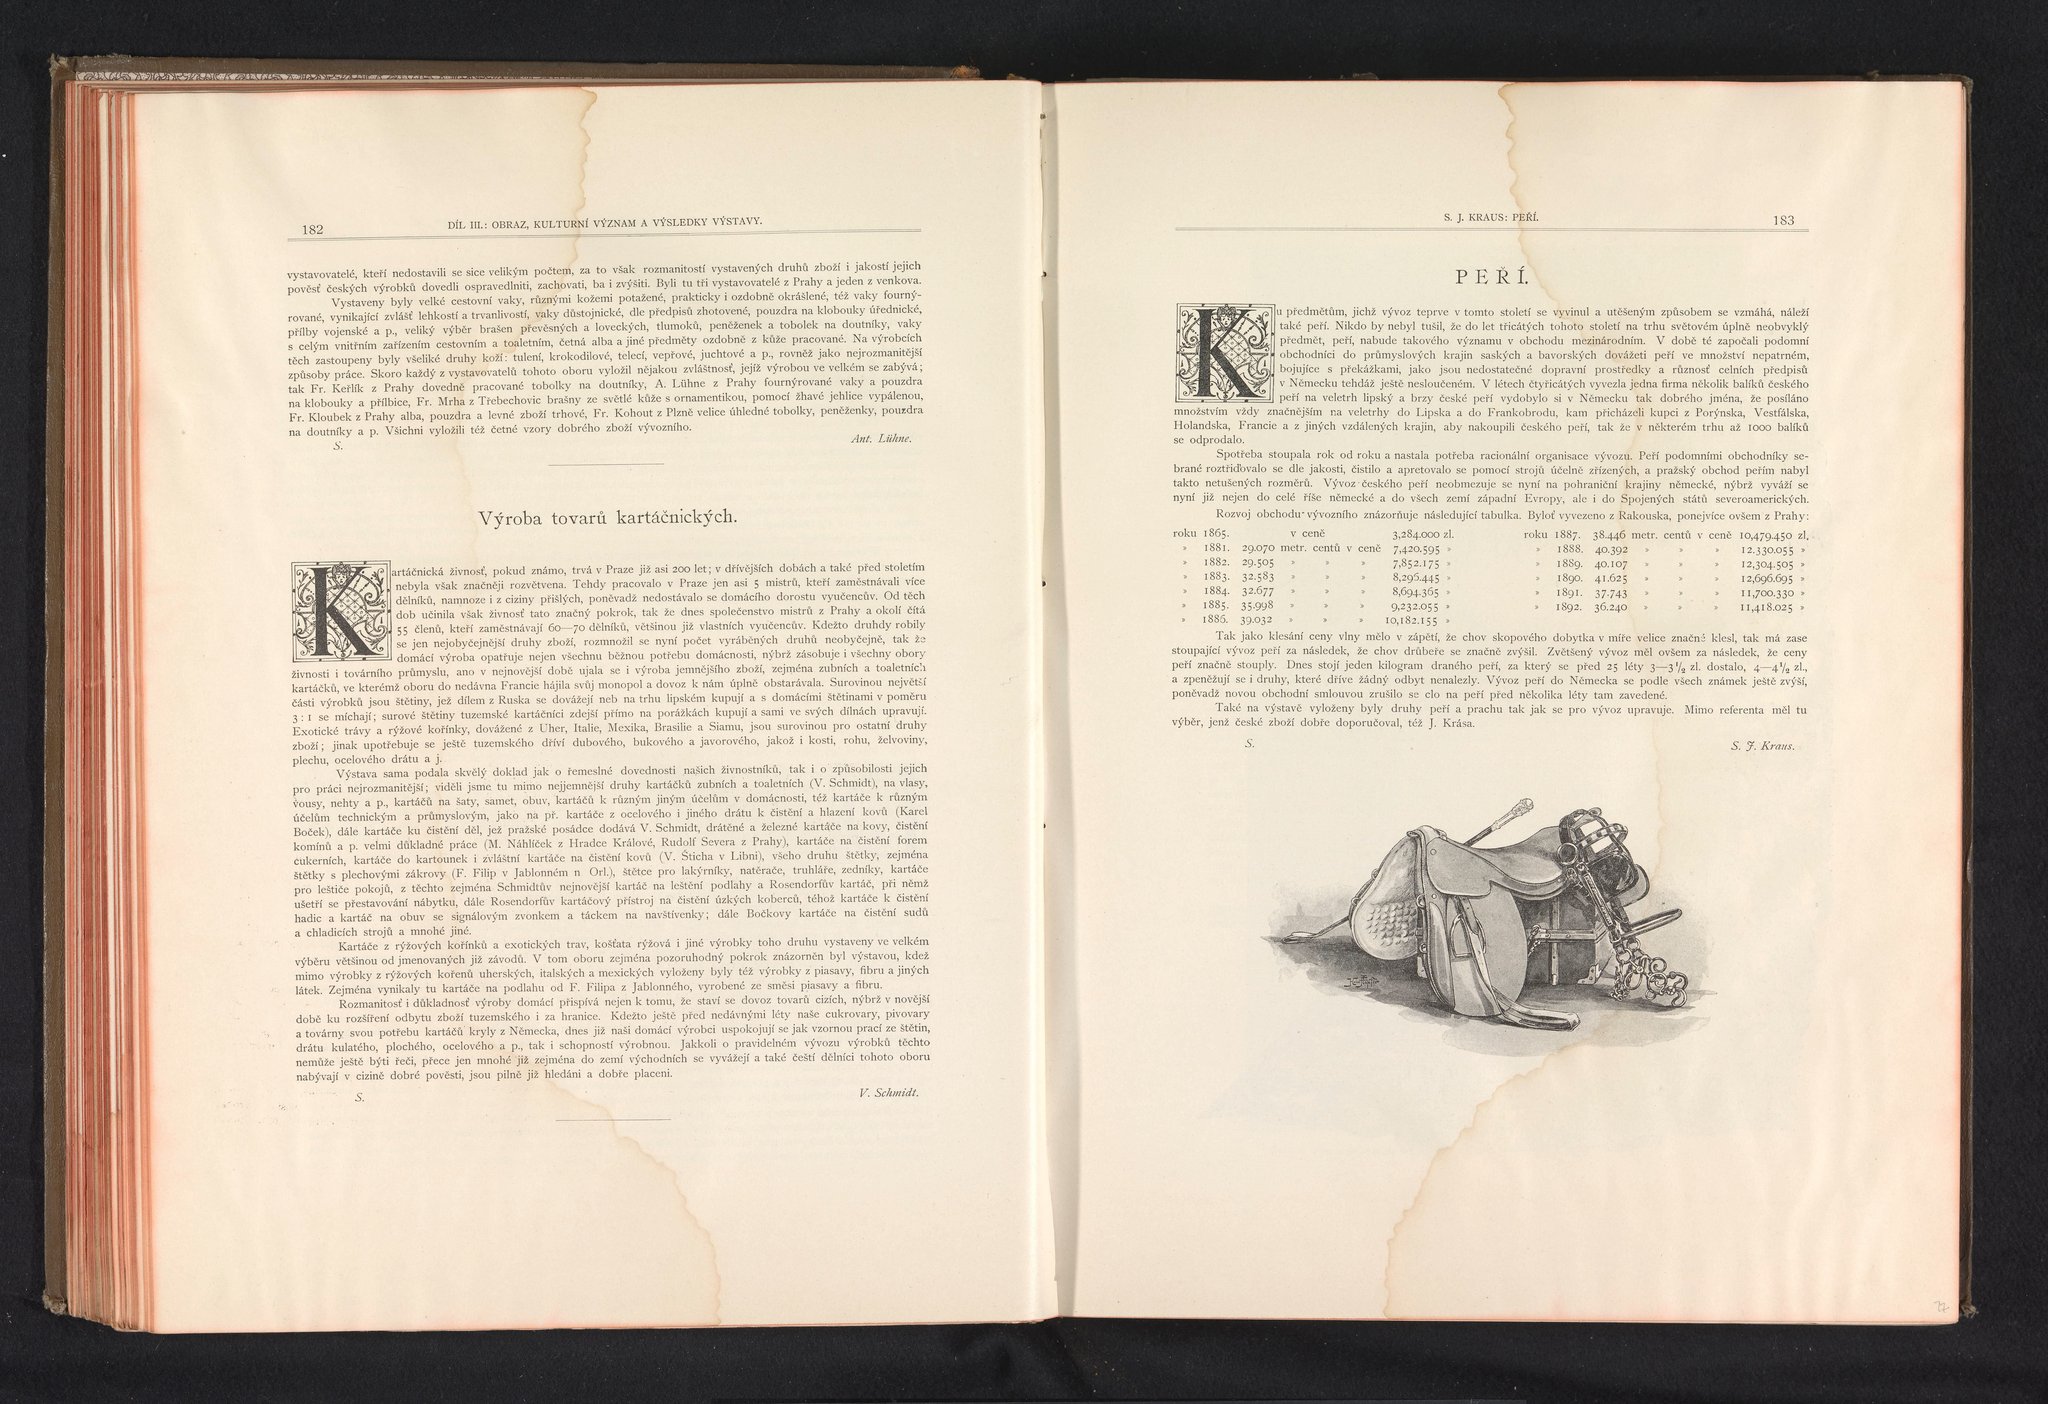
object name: page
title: Fotoreproductie van een tekening, voorstellende een zadel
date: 1890-1895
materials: paper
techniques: autotype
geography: prague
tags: saddle